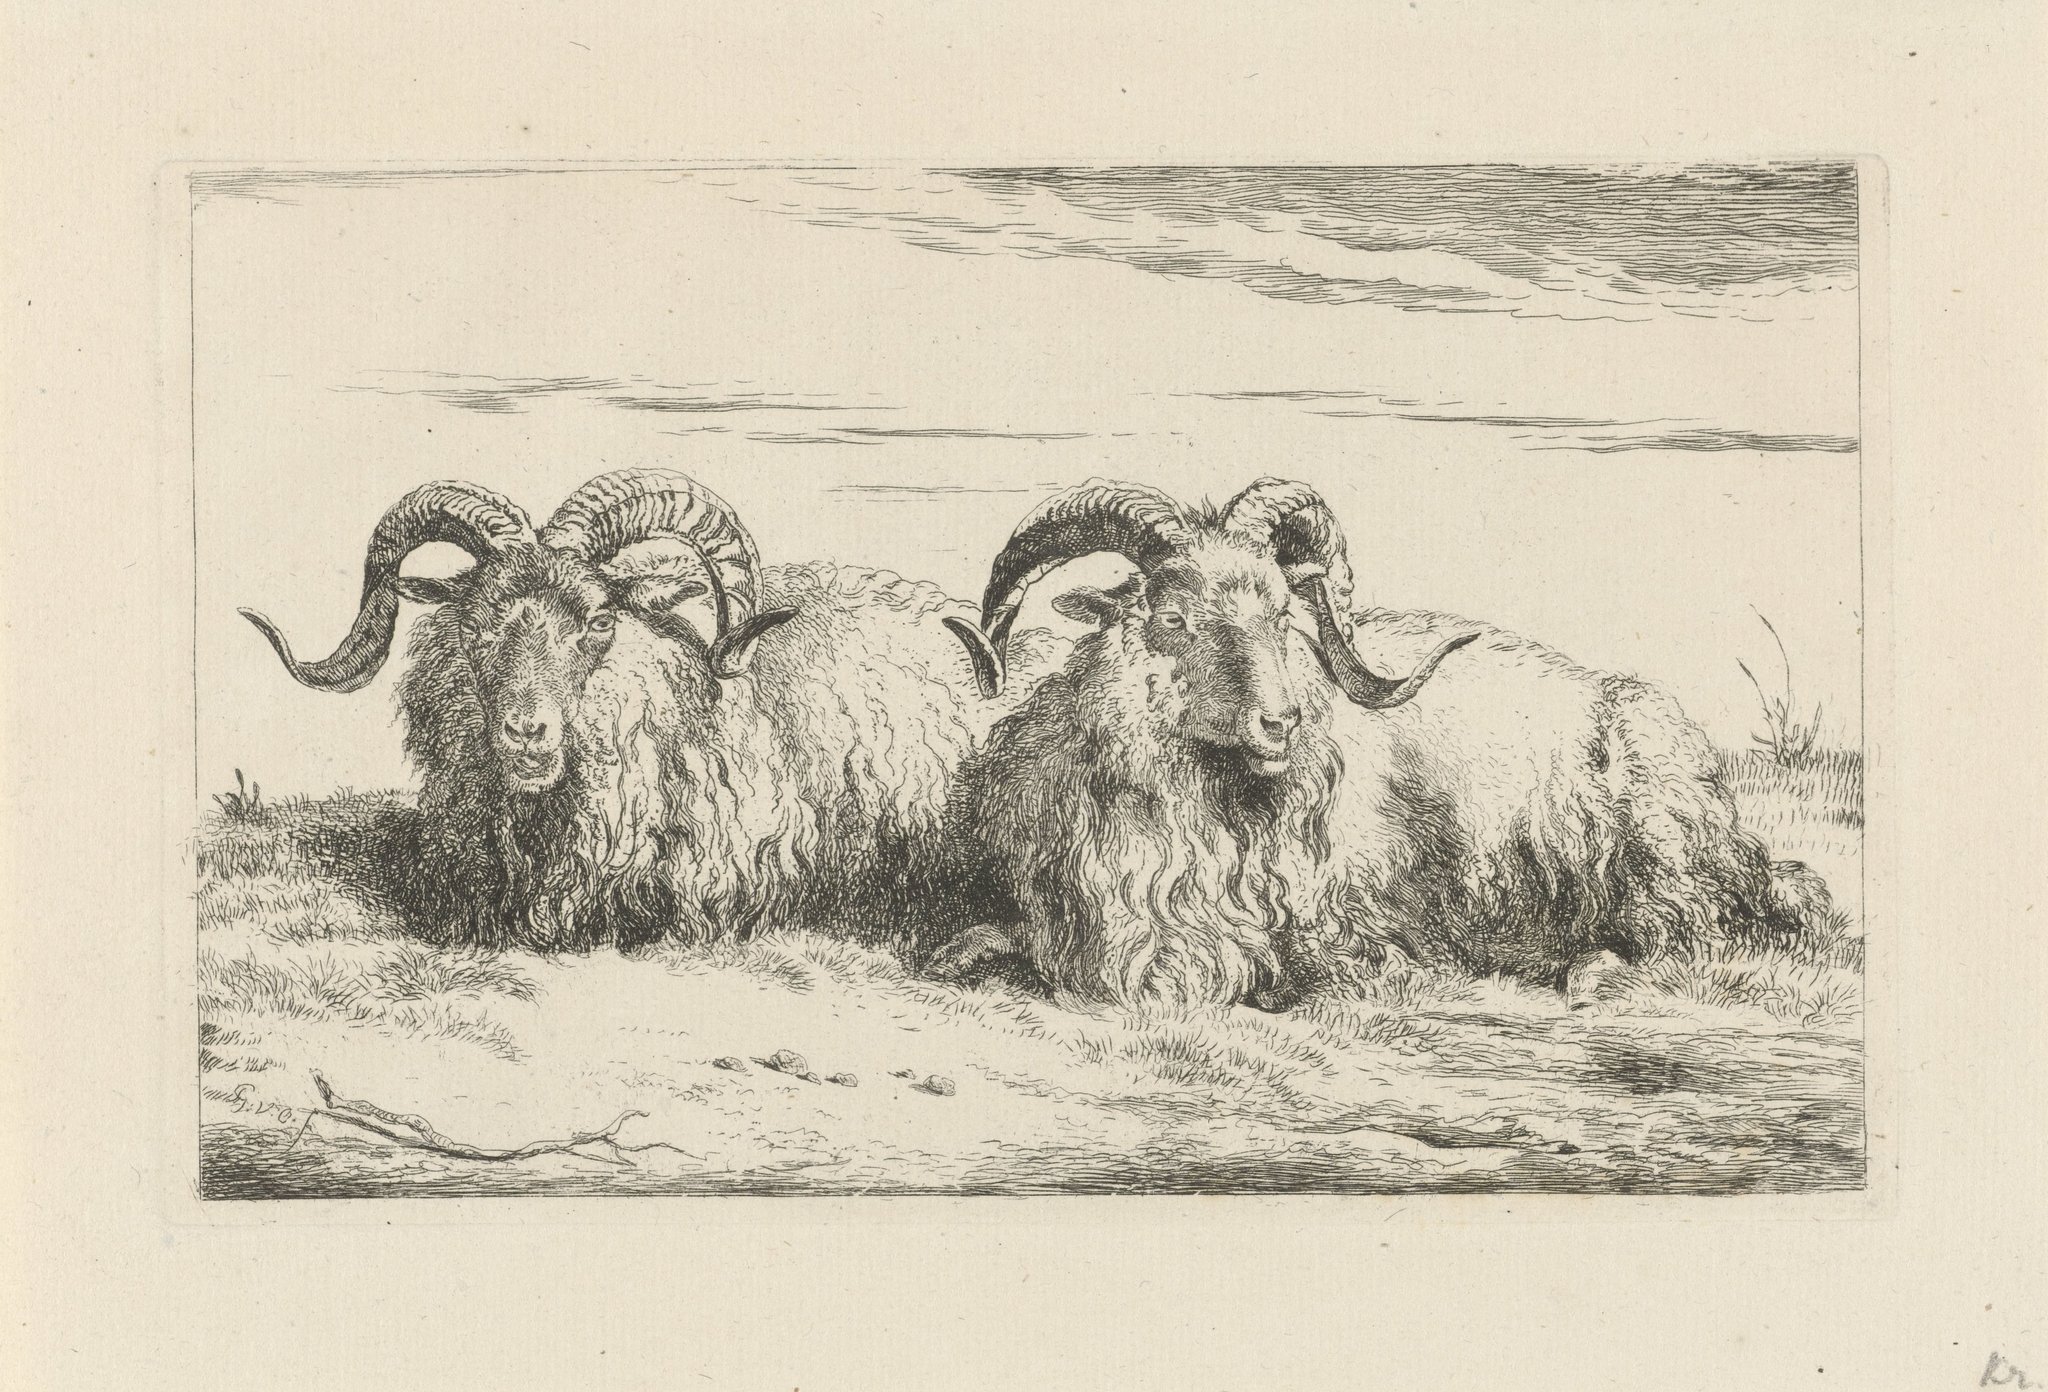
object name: print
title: Twee liggende rammen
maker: pieter gerardus van os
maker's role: draughtsman, painter, print maker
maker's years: 1776-1839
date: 1791-1839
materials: paper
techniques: etching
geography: netherlands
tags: ram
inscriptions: collector's mark: Lugt 2228